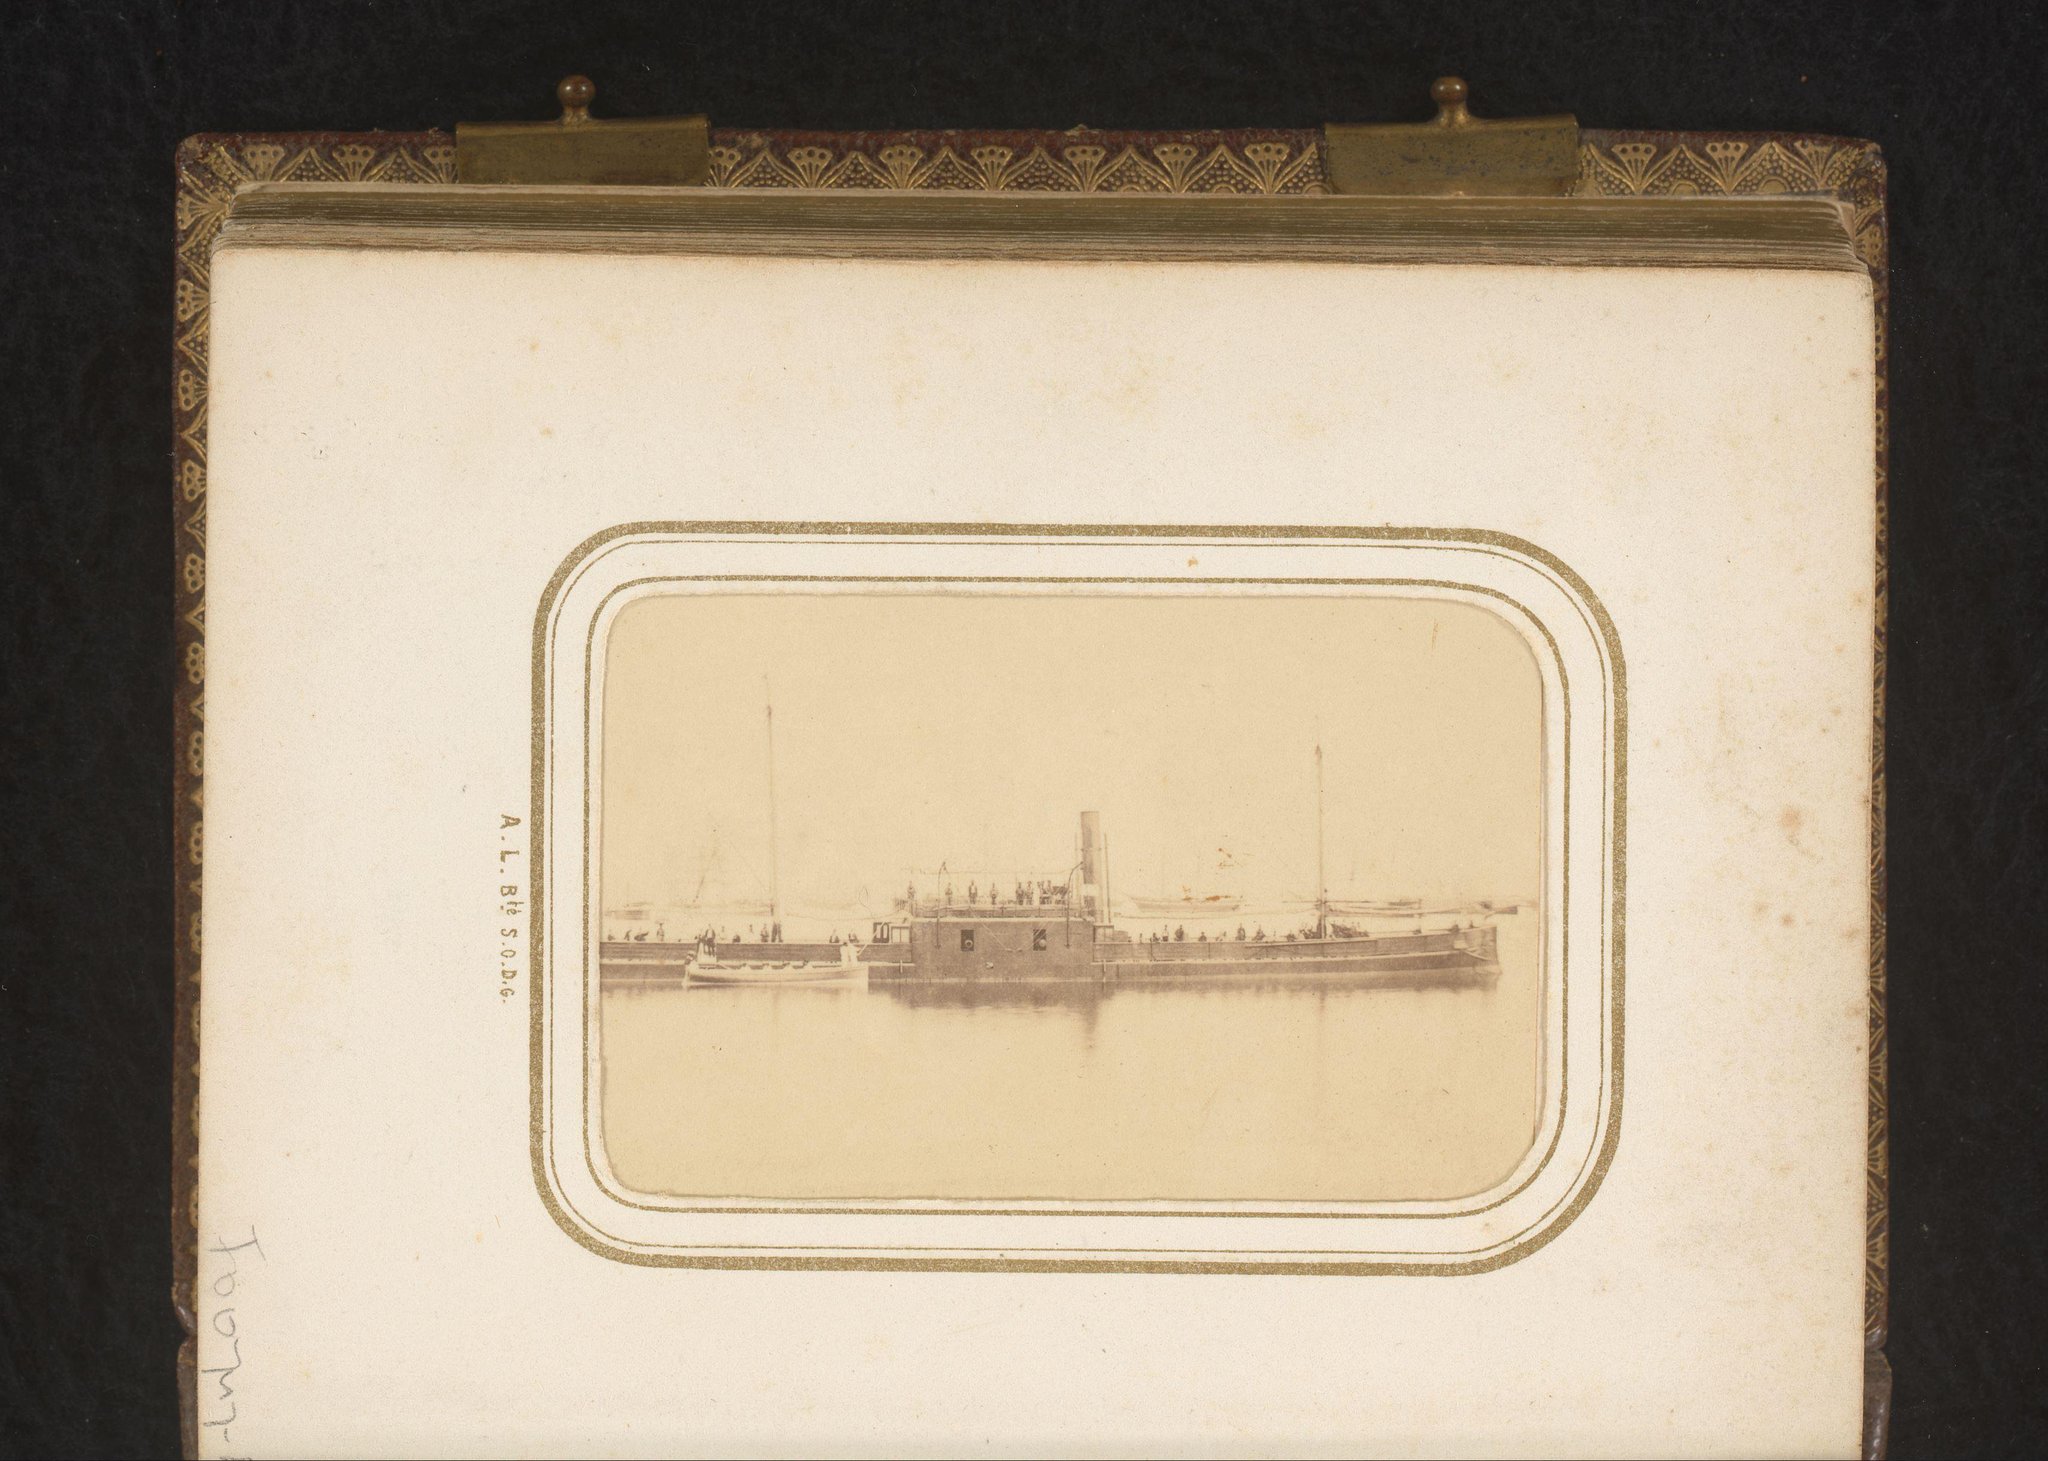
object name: carte de visite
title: Bemanningsleden op een schip in een haven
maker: marc ferrez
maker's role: fotograaf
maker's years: 1843-1923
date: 1860-1870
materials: cardboard, photographic support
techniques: albumen print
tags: crew ~ ship, ships (in general)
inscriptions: inscription: ‘A.L. B.te S.C.D.G.’, inscription: ‘Photographia/ Brazileira/ 96, Rua de S. José, 96/ (Antiga do Parto)/ Rio de Janeiro’